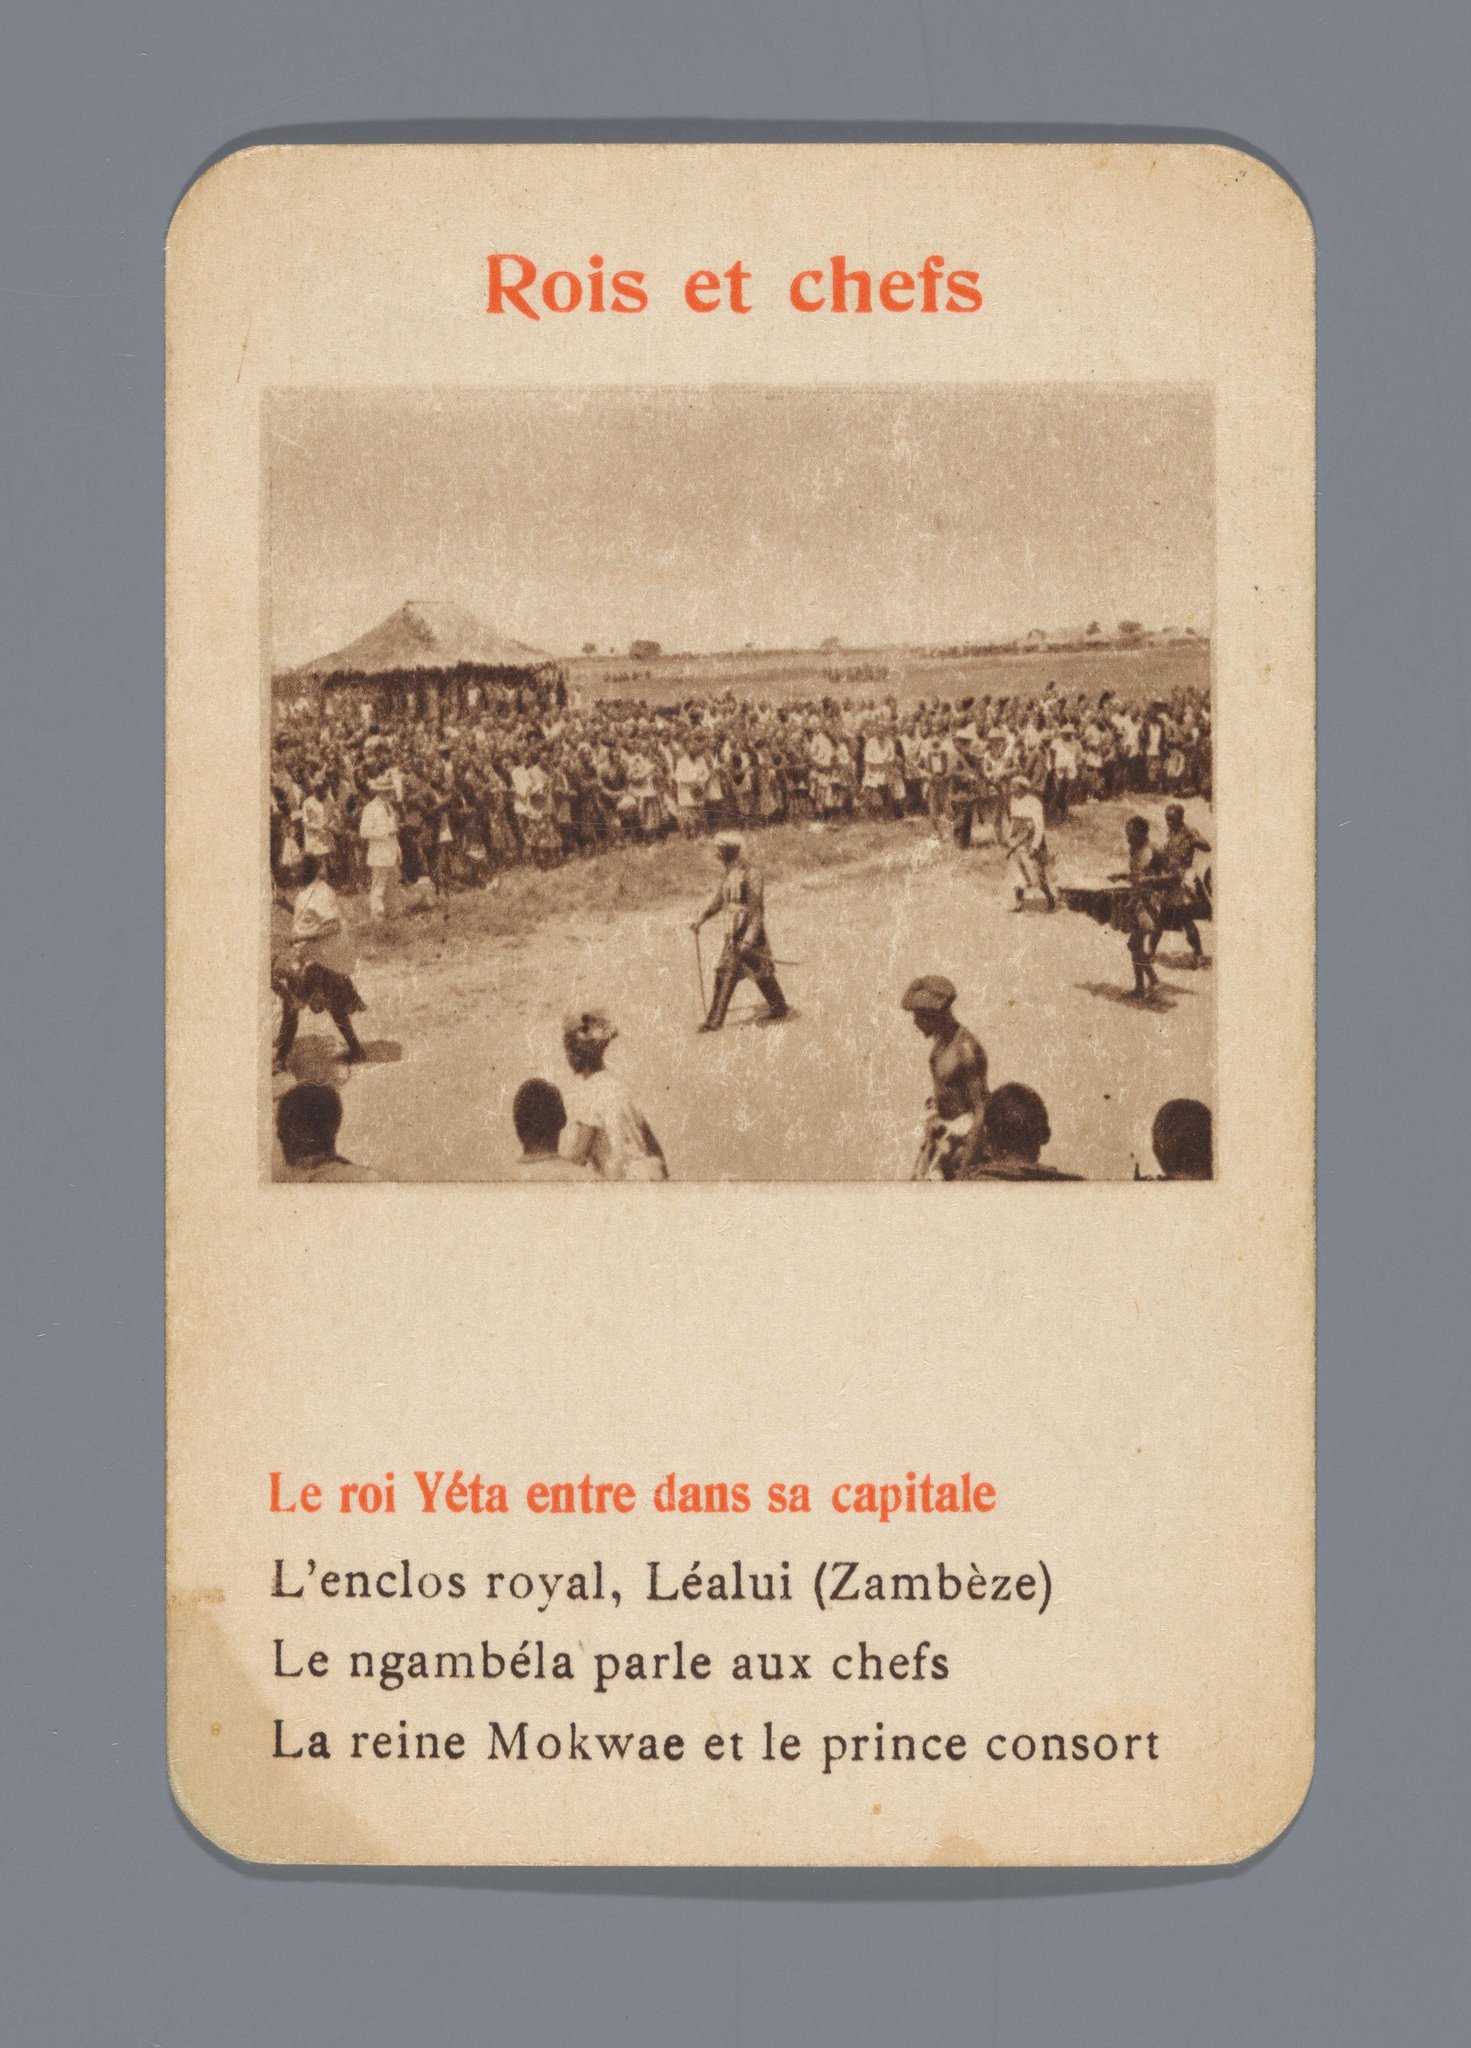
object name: card game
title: Ontvangst van koning Yeta III van Barotseland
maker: Anonymous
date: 1900-1920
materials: cardboard, paper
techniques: rotogravure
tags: clans, tribal relationships, card games, king